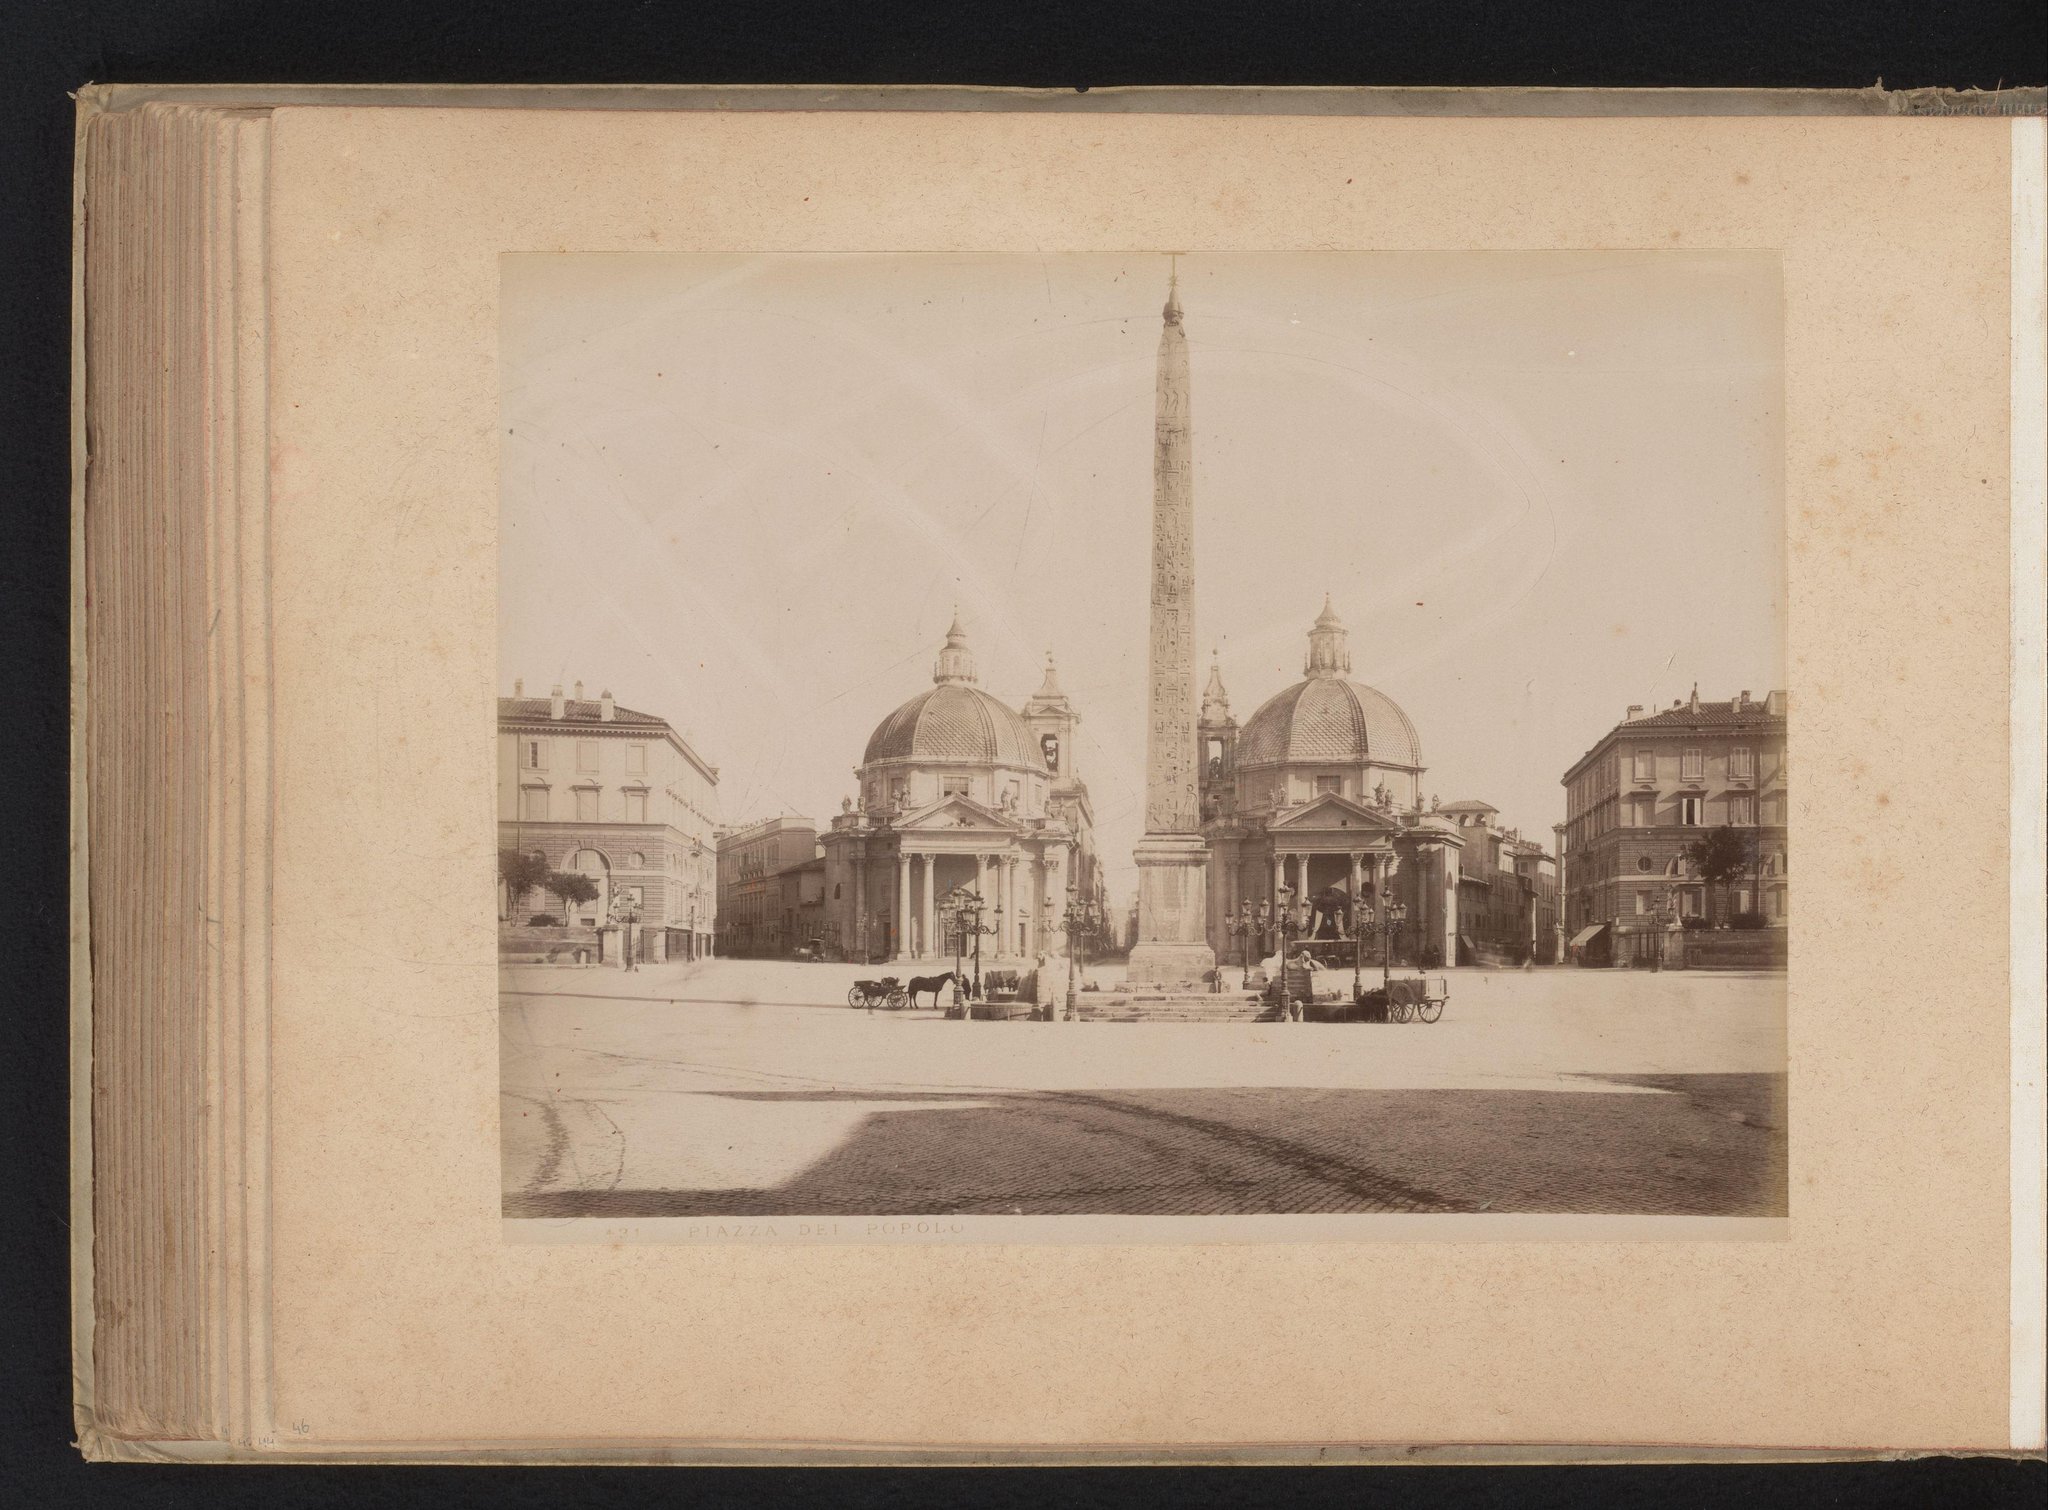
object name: album leaf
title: Gezicht op het Piazza del Popolo in Rome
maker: Anonymous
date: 1870-1895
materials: cardboard, photographic support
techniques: albumen print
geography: rome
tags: square, place, circus, etc., triumphal column with helical friezes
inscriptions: inscription: ‘431 PIAZZA DEL POPOLO’